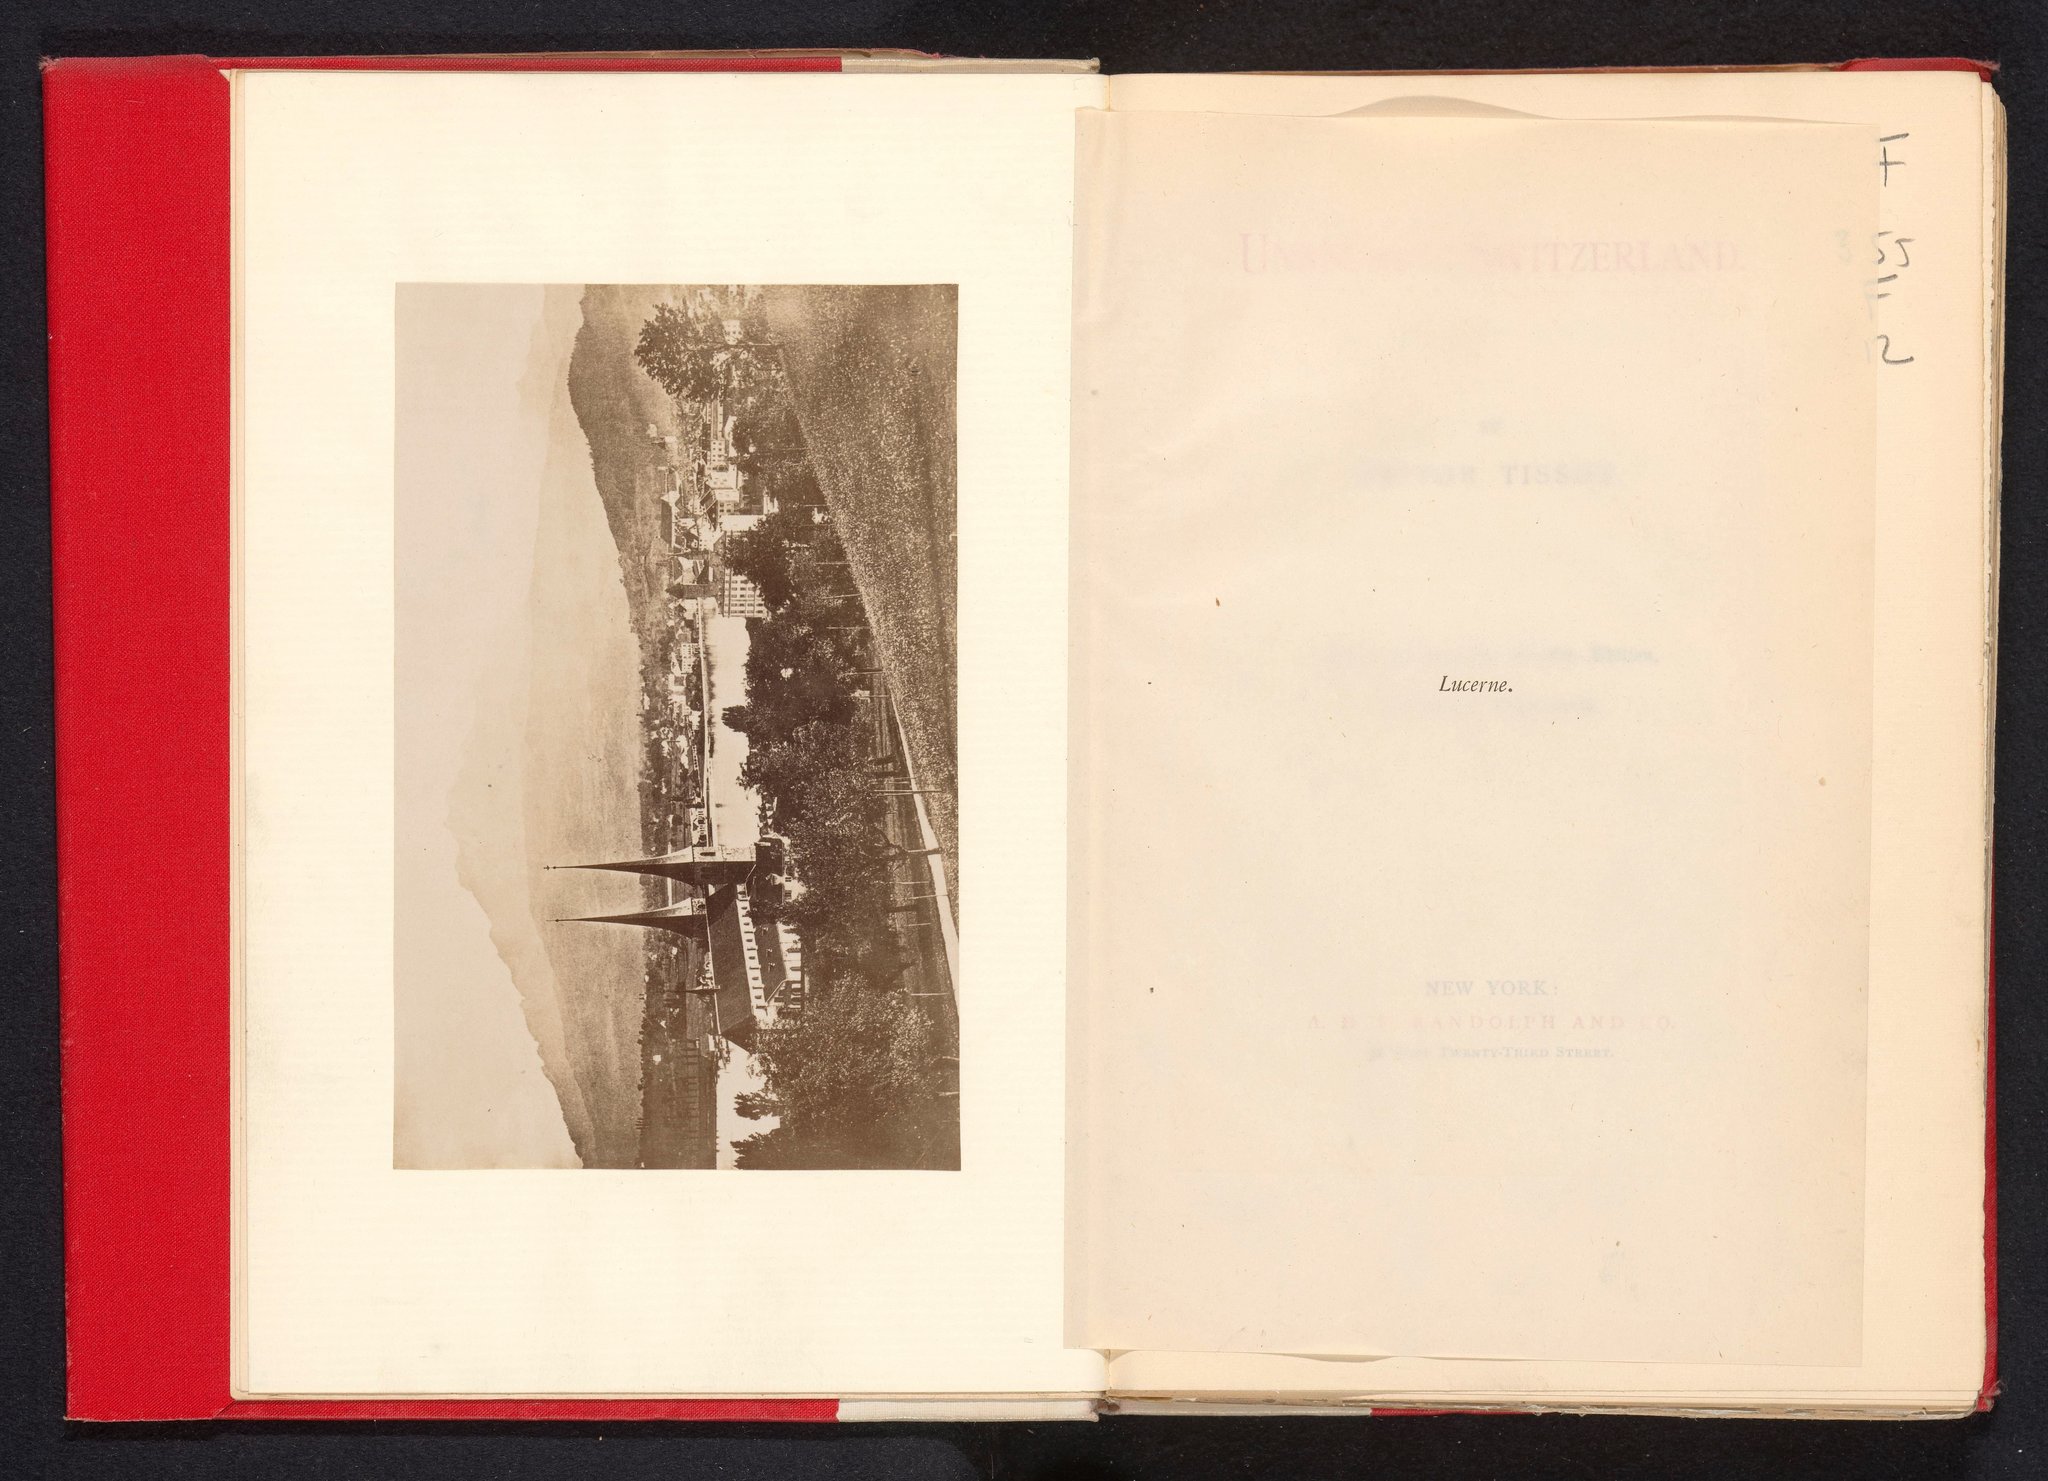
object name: page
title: Lucerne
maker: Anonymous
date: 1879-1889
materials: photographic support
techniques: albumen print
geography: switzerland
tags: city-view, and landscape with man-made constructions